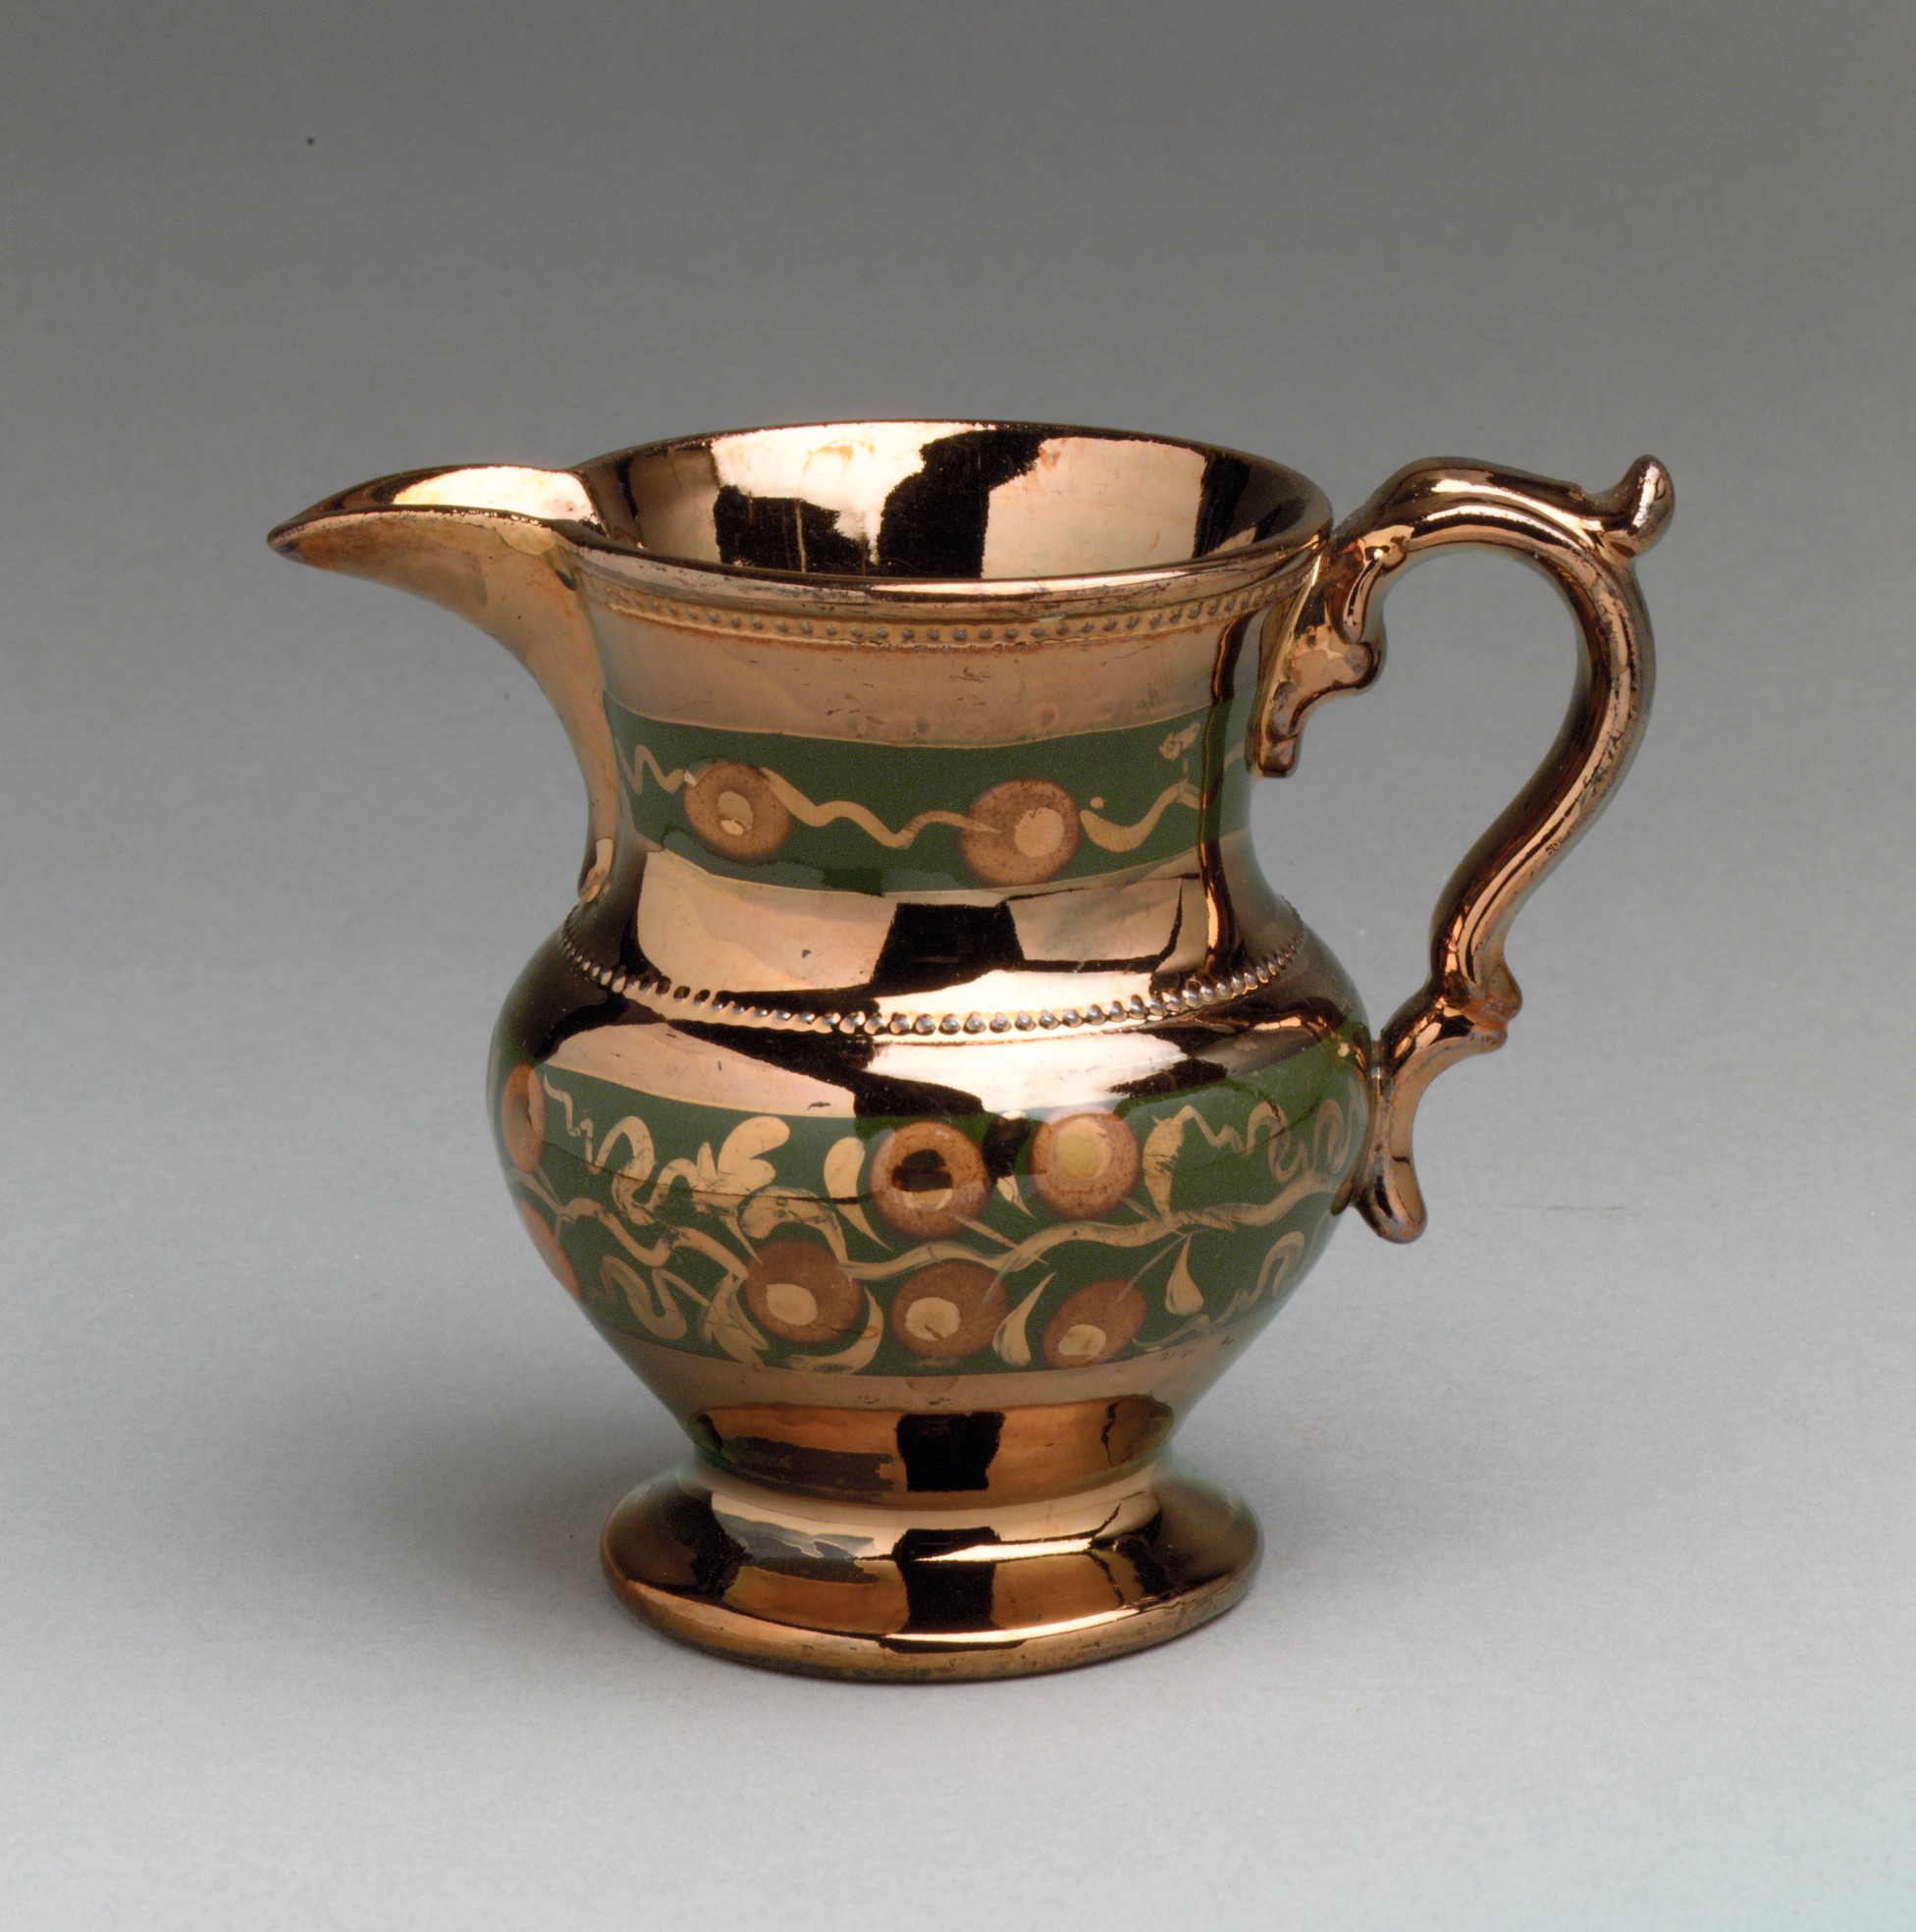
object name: pitcher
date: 1801-1900